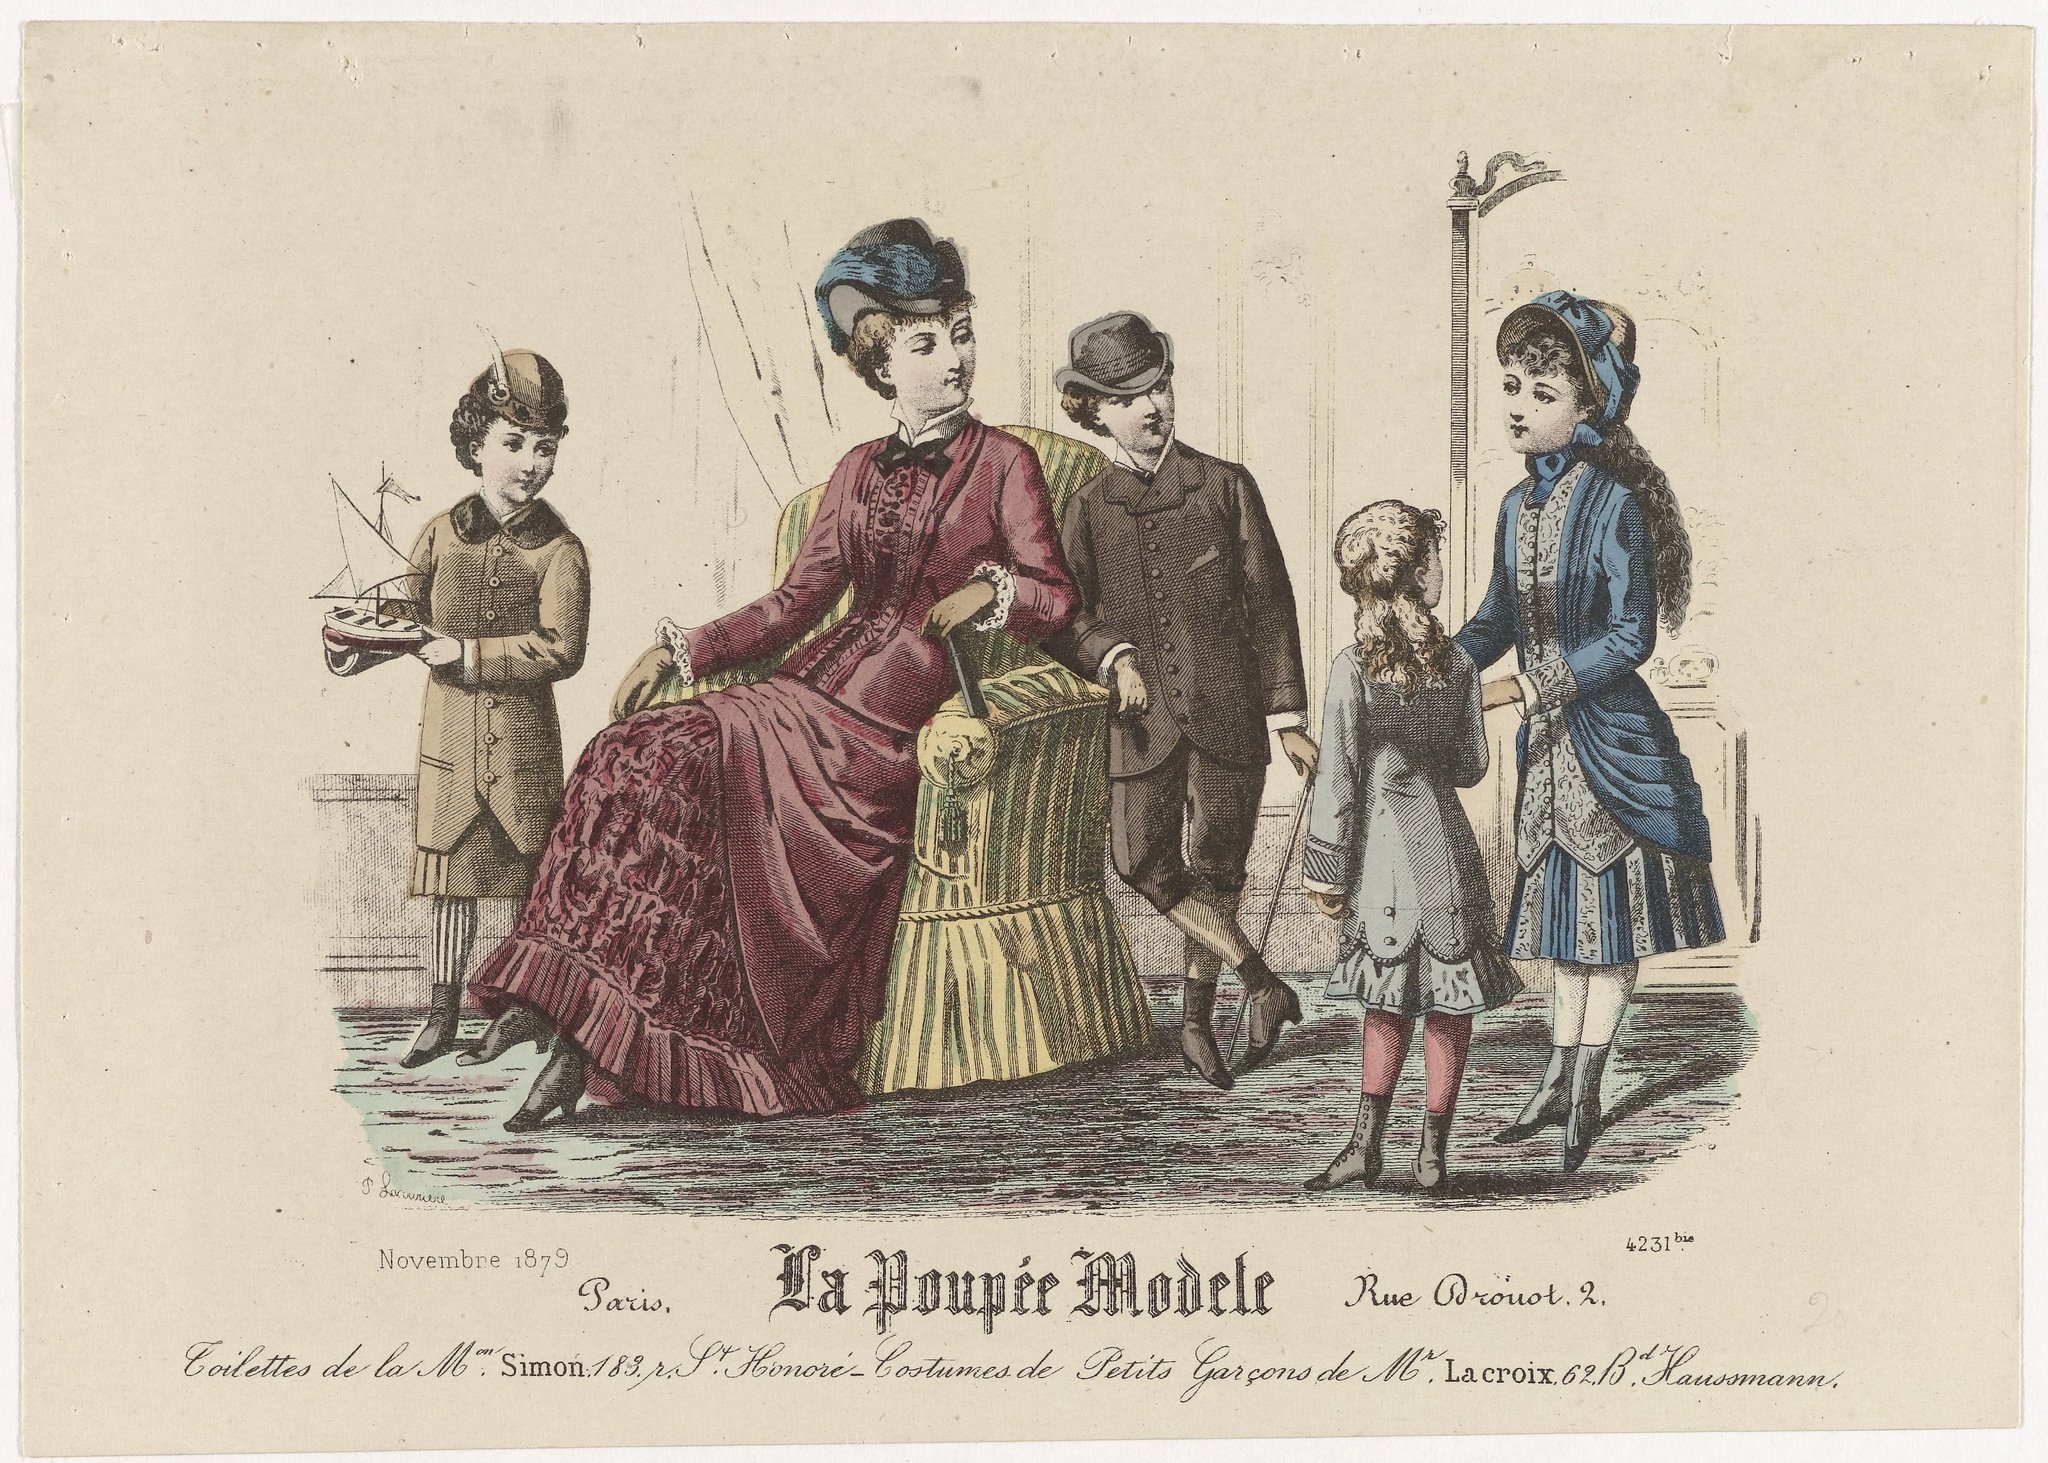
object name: fashion print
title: La Poupée Modele, novembre 1879, No. 4231 bis : Toilettes de la Mon Simon (...)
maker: Anonymous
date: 1879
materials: paper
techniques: engraving, hand coloring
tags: trousers, breeches (+ boys' clothes), head-gear (+ girls' clothes), walking-stick, staff, cane (+ boys' clothes), clothing for the upper part of the body (+ boys' clothes), boots (+ girls' clothes), head-gear (+ boys' clothes), fashion plates, head-gear: hat (+ women's clothes), shoes, sandals (+ women's clothes), dress, gown (+ girls' clothes), (playing with) boats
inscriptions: title: ‘La Poupée Modele’, address: ‘Paris, Rue Drouot. 2.’, caption: ‘Toilettes de la M.on Simon. 183.r. S.t Honoré _ Costumes de Petits Garçons de M.r Lacroix 62 B.d Haussmann.’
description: Een vrouw en vier kinderen in interieur. Volgens het onderschrift zijn de japonnen van de firma Simon. De jongens kleding is van Mr Lacroix.